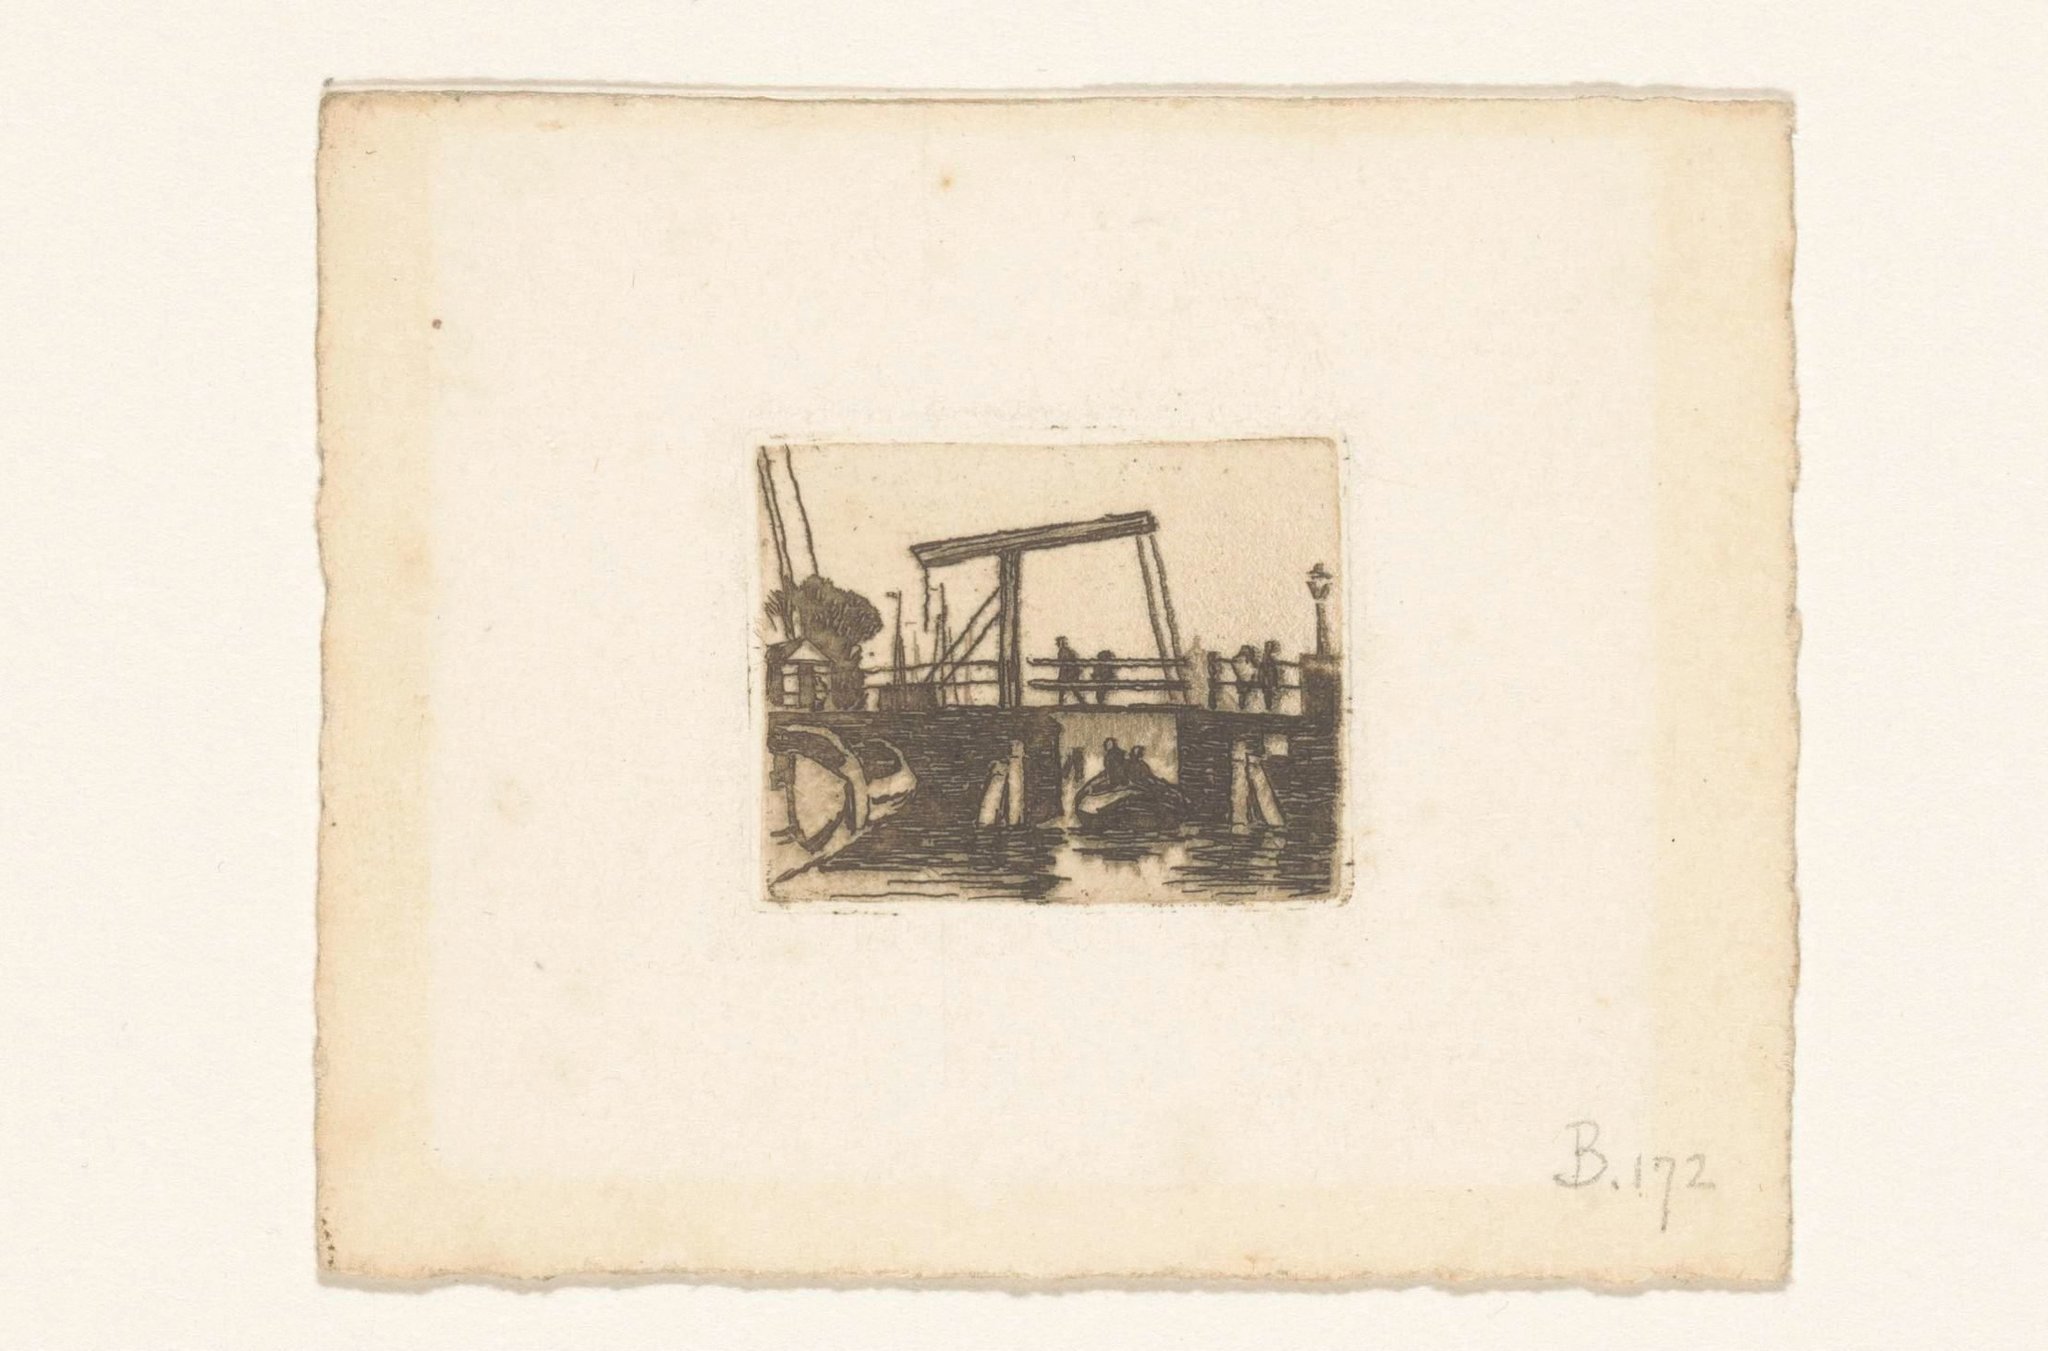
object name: print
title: Kikkerbilsluis in Amsterdam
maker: willem witsen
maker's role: draughtsman, painter, print maker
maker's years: 1860-1923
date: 1913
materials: paper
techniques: etching, intaglio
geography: amsterdam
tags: canals, waters (in city), bridge, boat propelled by man or animal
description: De verbinding tussen de Oude Schans en het Oosterdok.